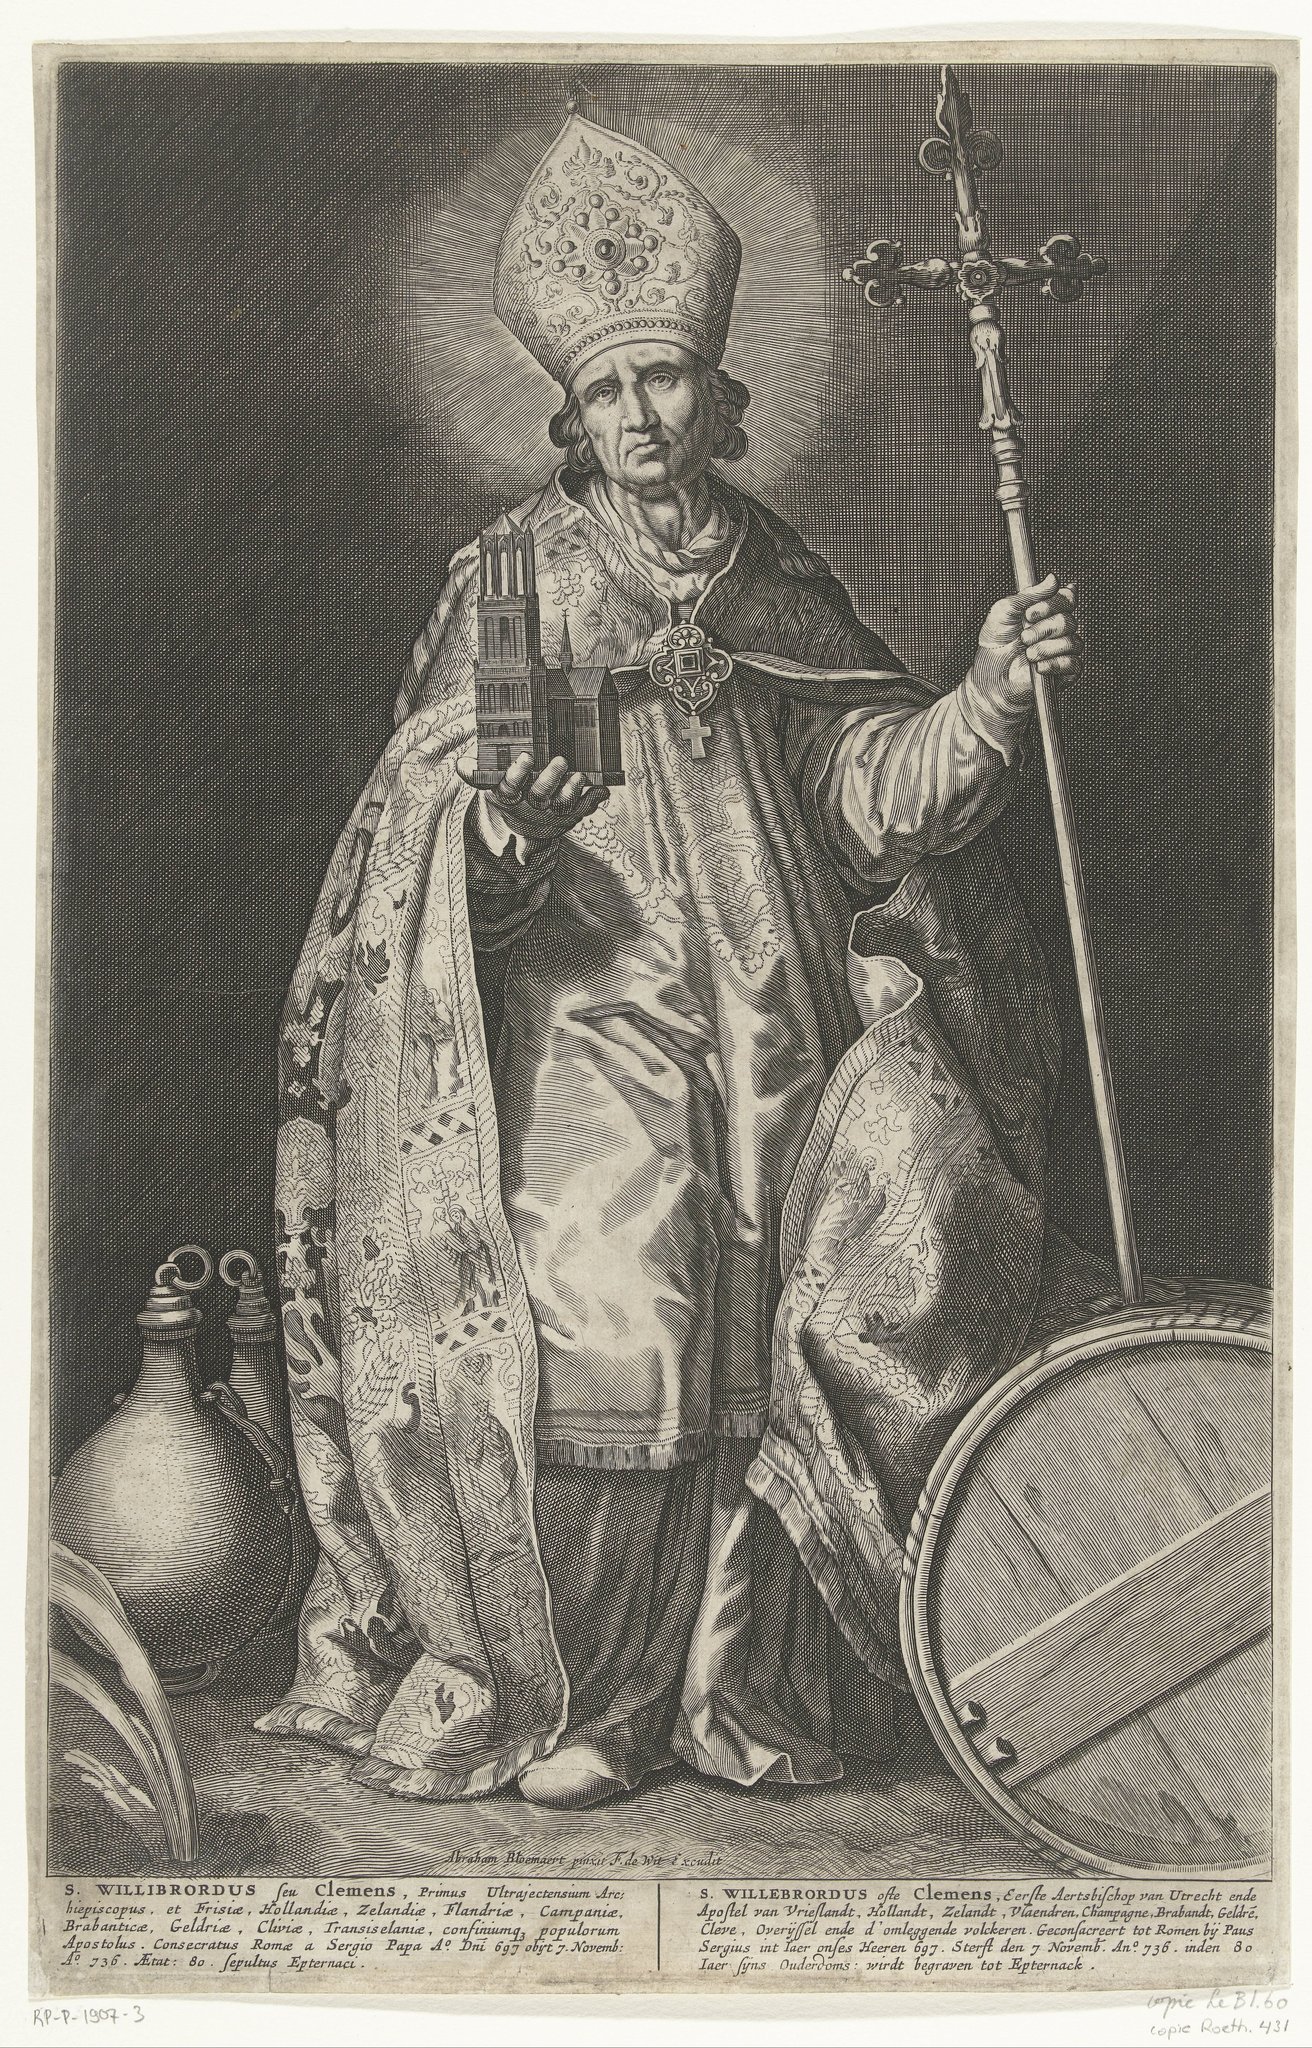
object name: print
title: De heilige Willibrordus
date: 1630-1700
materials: paper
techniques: engraving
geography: amsterdam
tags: the 'apostle of frisia' and archbishop of utrecht, willibrord (of echternach); possible attributes: cask (barrel), well (fountain), child (on a book), model of church, stone bottles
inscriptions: collector's mark: Lugt 2228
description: Willibrordus, de eerste bisschop van Utrecht, is hier afgebeeld in bisschopsgewaad met mijter en staf. Hij draagt een model van de domkerk van Utrecht in zijn hand. Kopie van een prent uit een serie met twaalf prelaten en bisschoppen van Utrecht.